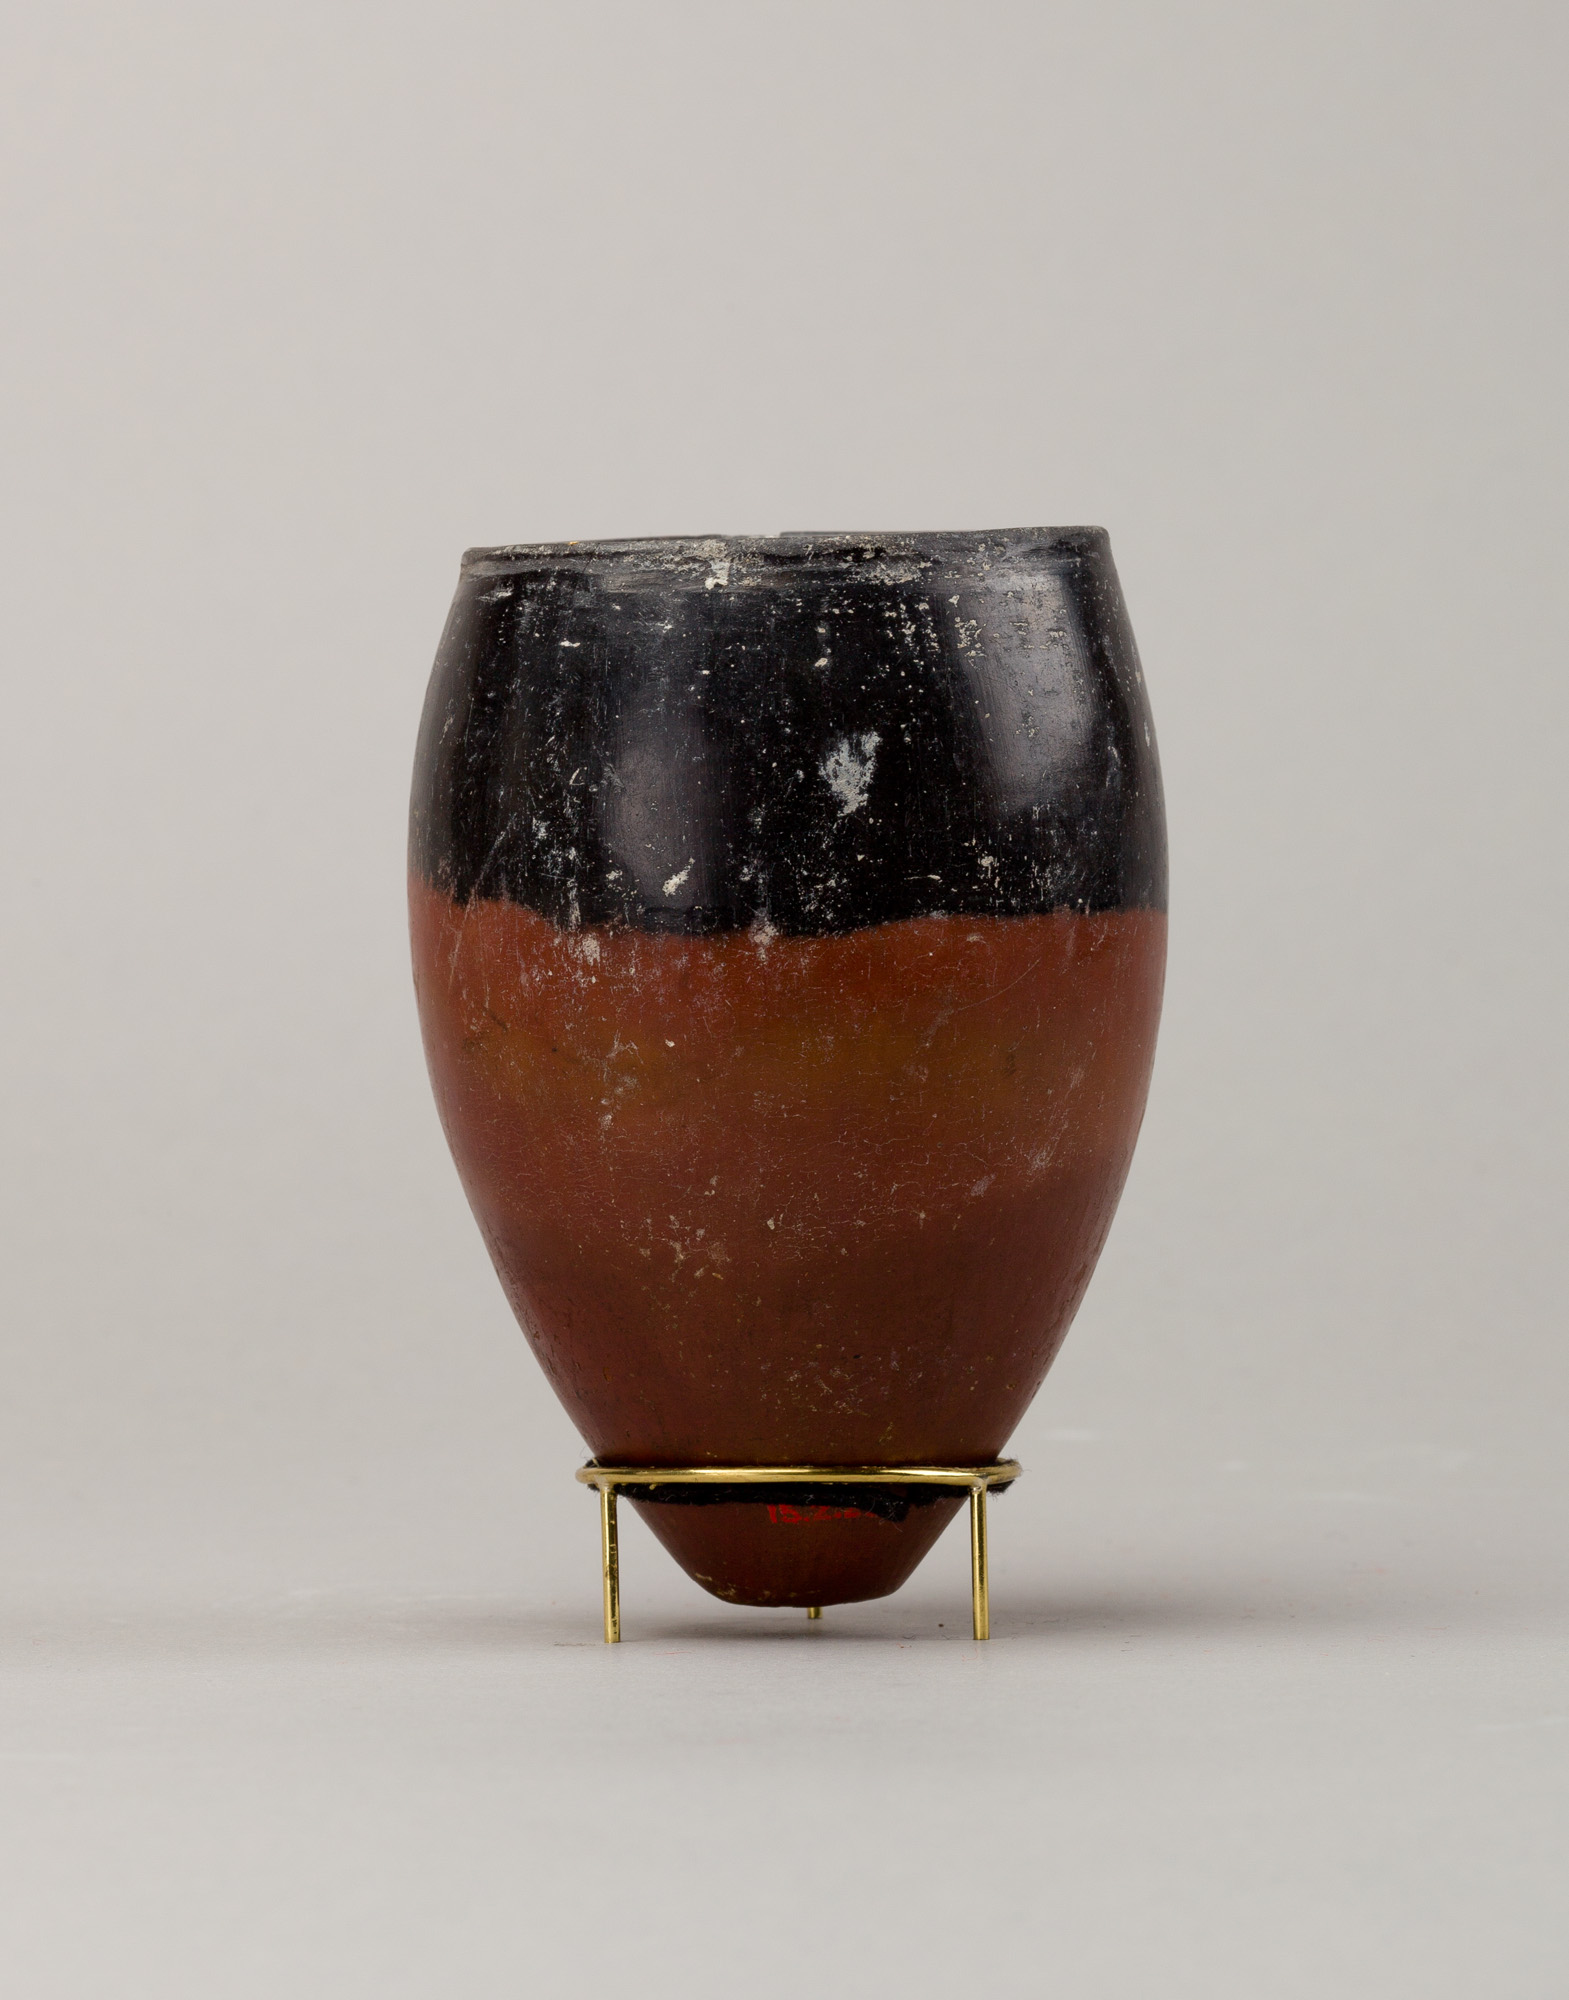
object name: jar, black topped red ware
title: Black-topped red ware jar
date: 3850-2960 BCE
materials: pottery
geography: egypt